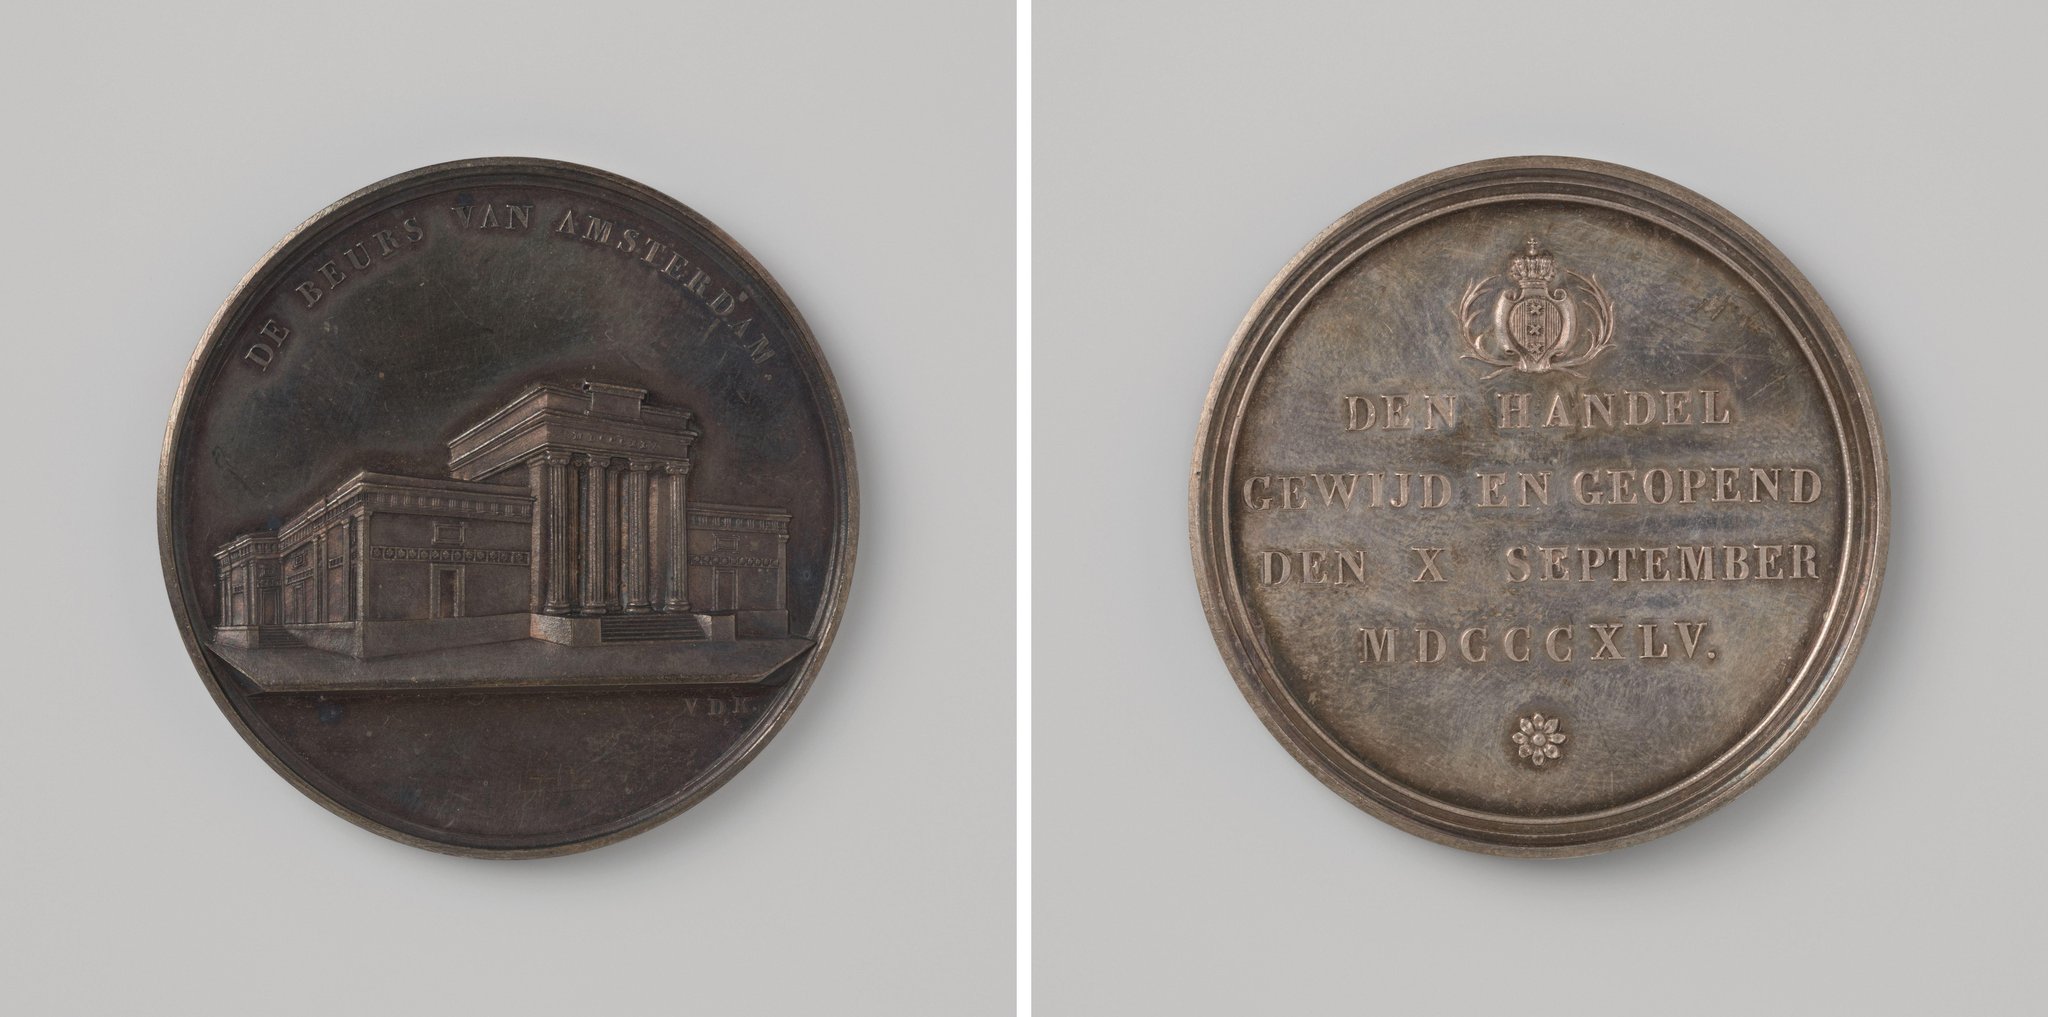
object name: history medal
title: Opening van de nieuwe Beurs te Amsterdam 1845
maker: david van der kellen (1804-1879)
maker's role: die cutter, draughtsman, print maker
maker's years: 1804-1879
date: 1845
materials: silver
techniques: striking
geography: utrecht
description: Zilveren penning, op de voorzijde de Beurs half van rechts, met omschrift bovenaan, op de keerzijde vier regels tekst, bovenaan een Amsterdams wapenschildje, onderaan een rozet.